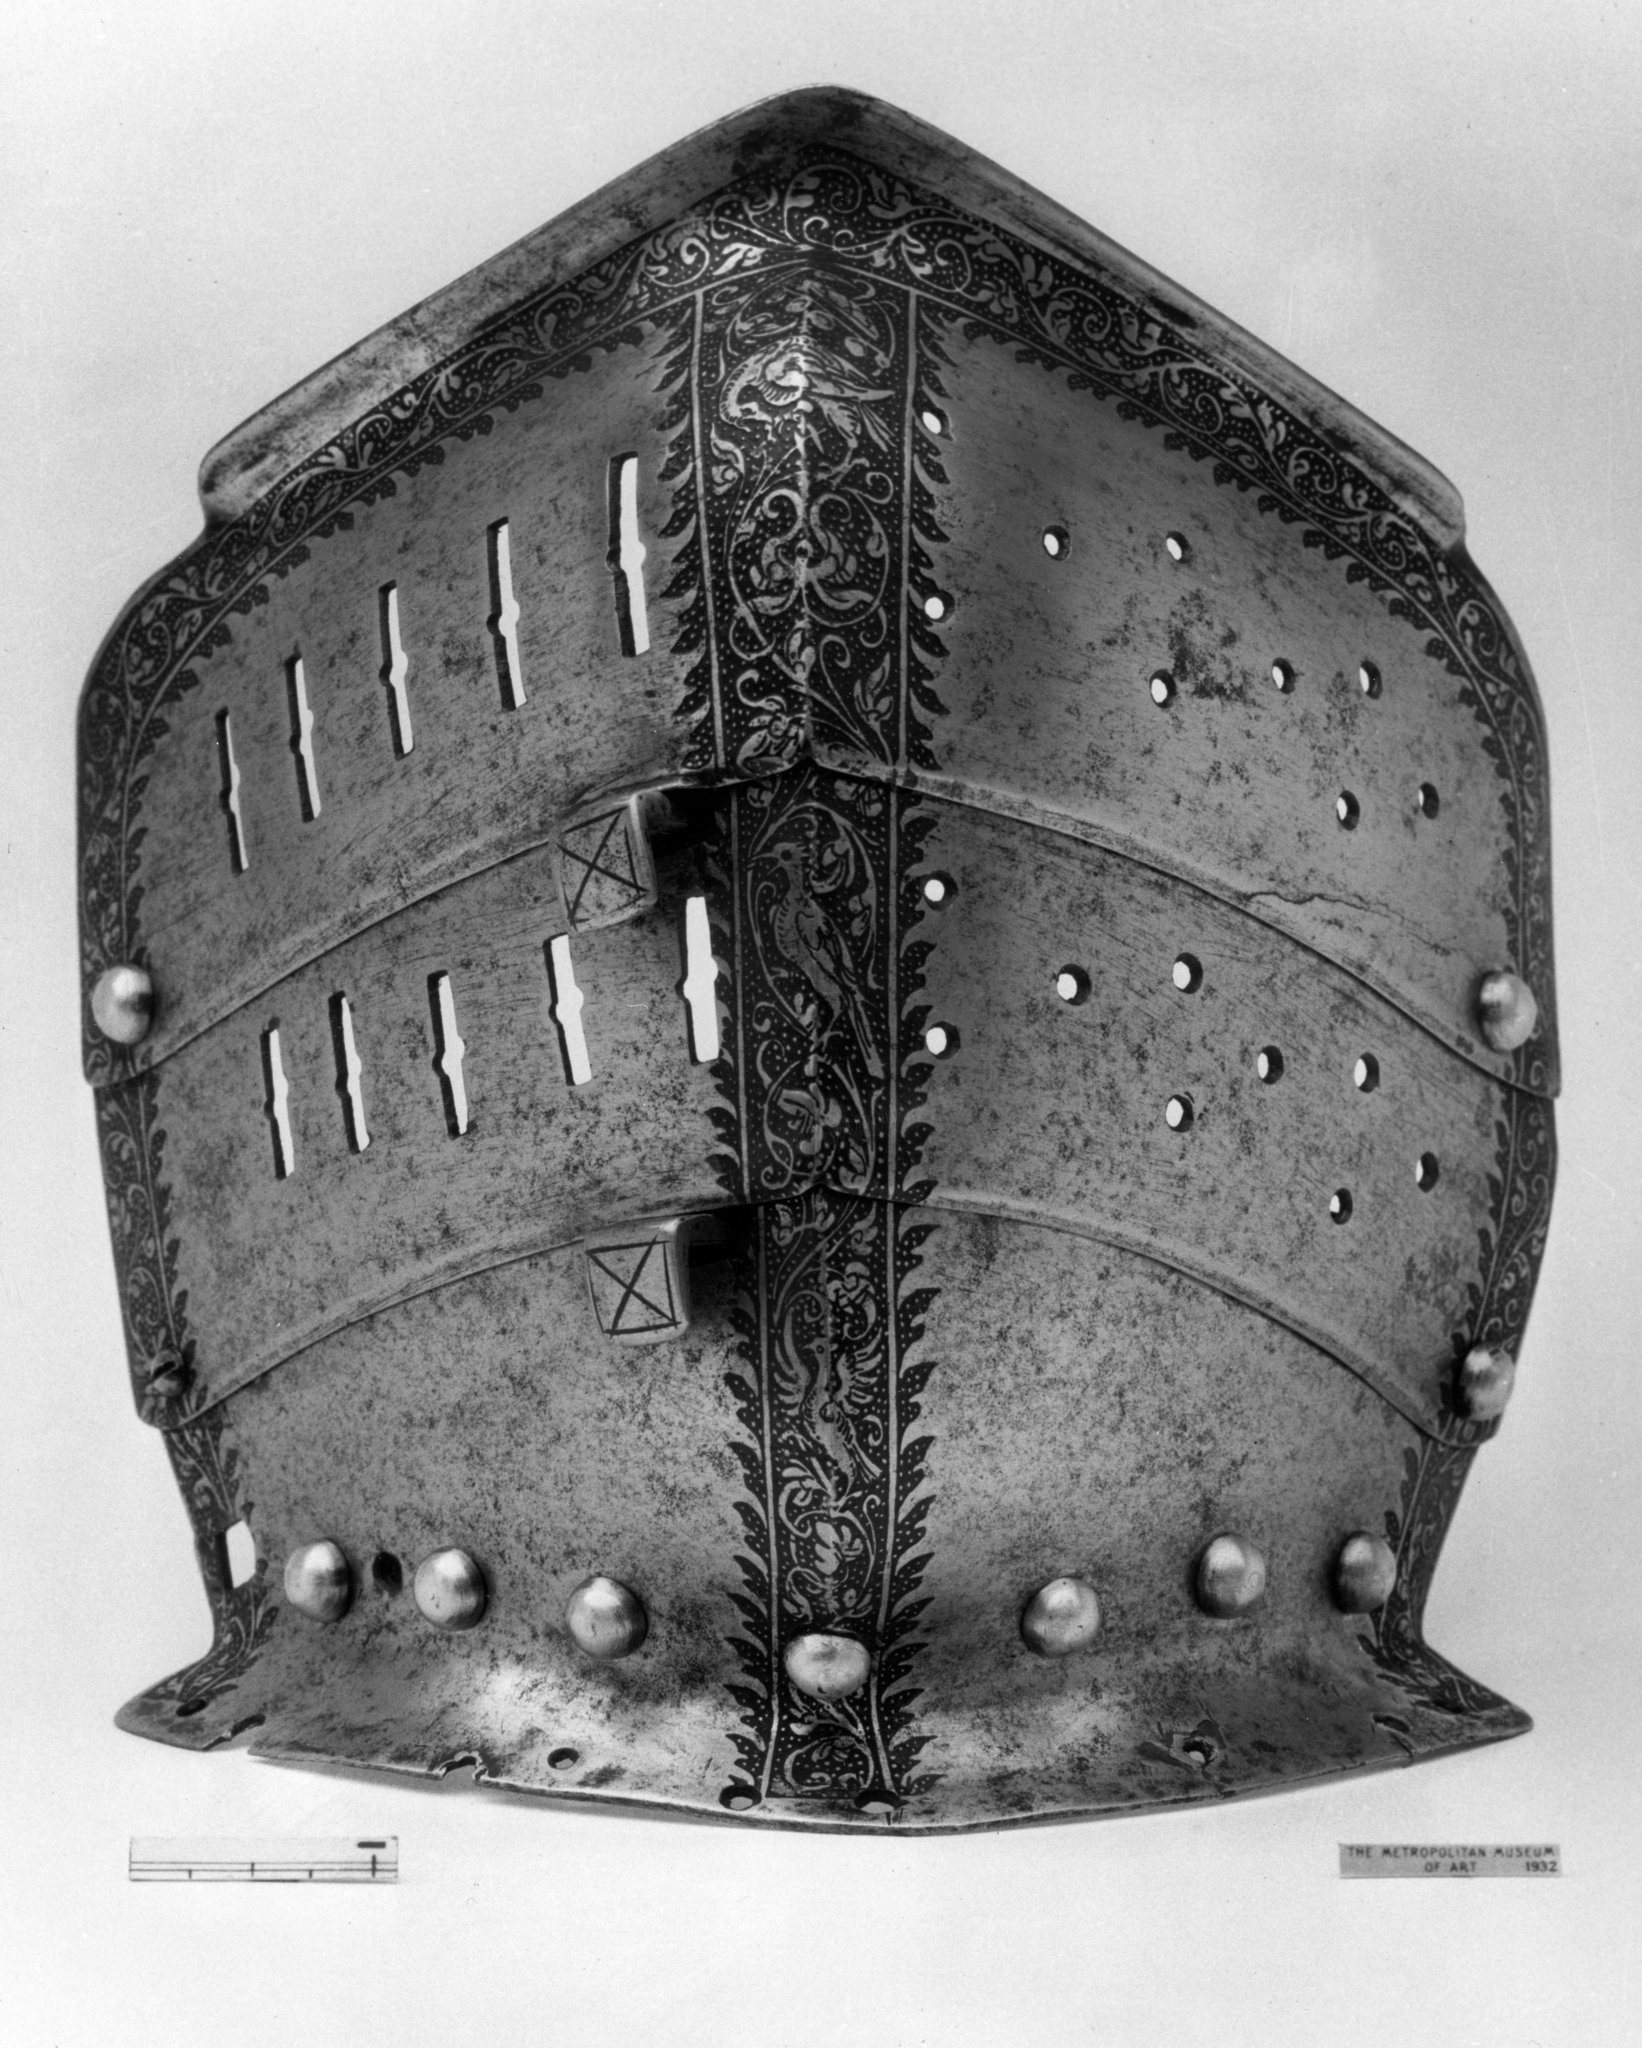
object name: falling buffe for a helmet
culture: german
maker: wolfgang grosschedel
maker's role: armorer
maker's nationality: german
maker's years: 1517-1562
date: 1555-1560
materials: steel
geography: germany